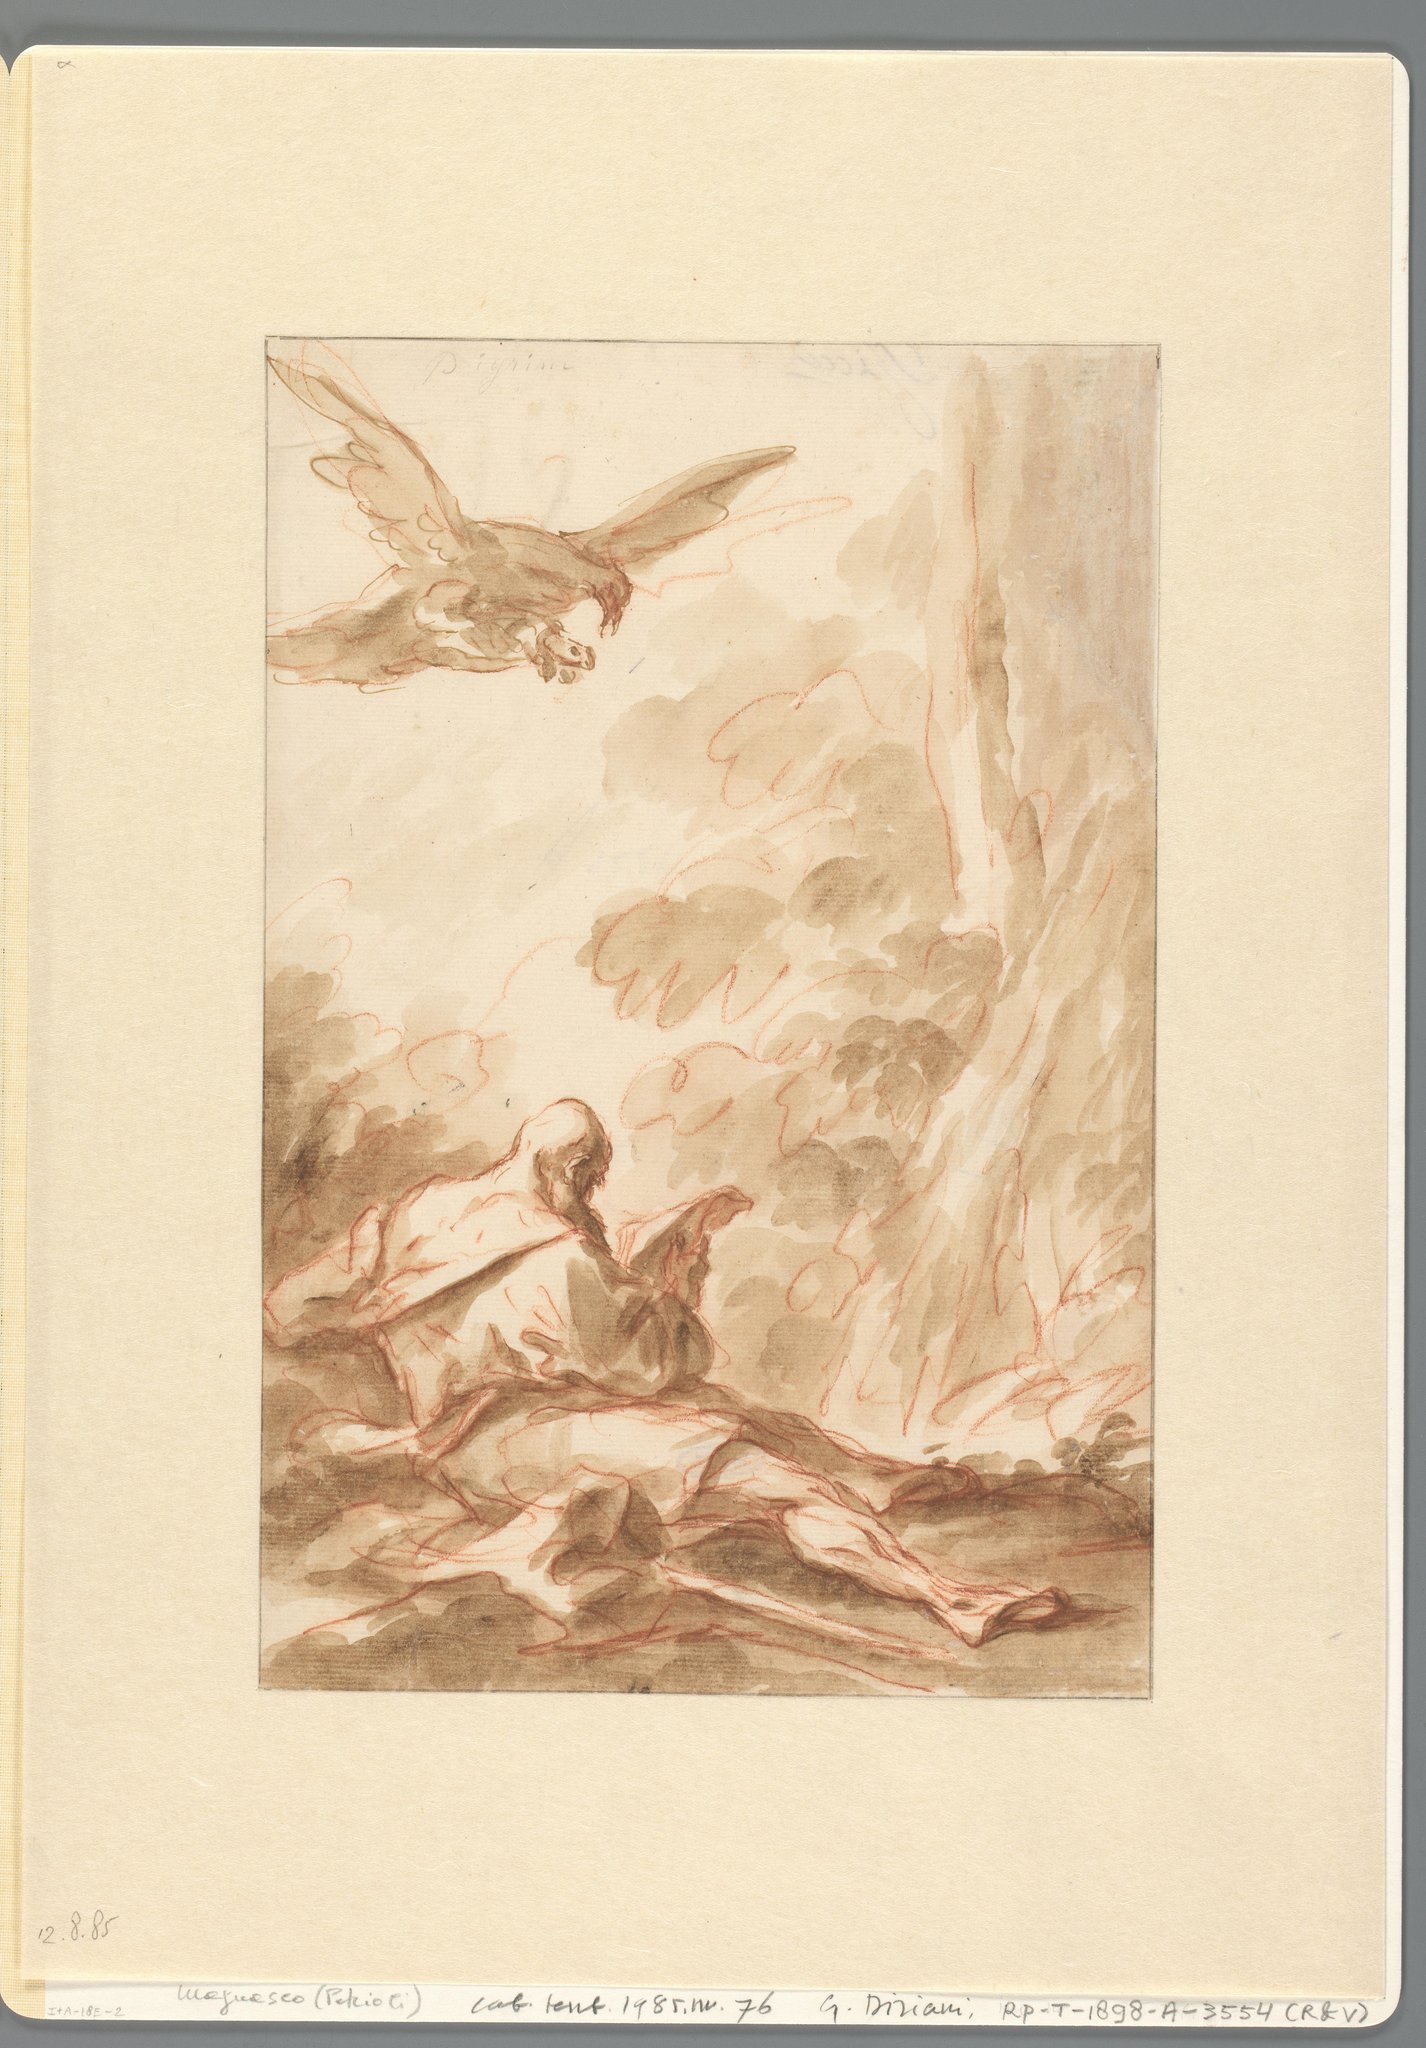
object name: drawing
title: Elia gevoed door de raven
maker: gasparo diziani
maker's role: draughtsman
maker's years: 1689-1767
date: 1750-1760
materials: chalk, ink, paper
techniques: brush, pen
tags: elijah fed by the raven(s): while the prophet is living by the brook, ravens bring him food